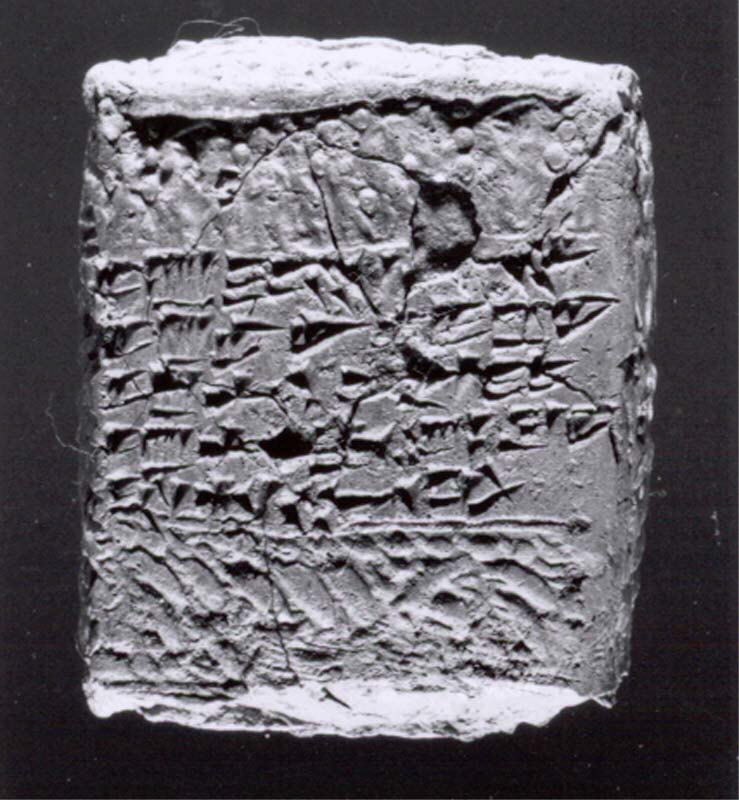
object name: cuneiform tablet case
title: Cuneiform tablet case impressed with three cylinder seals, for cuneiform tablet 66.245.14a: loan of silver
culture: assyrian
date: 2000-1801 BCE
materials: clay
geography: anatolia